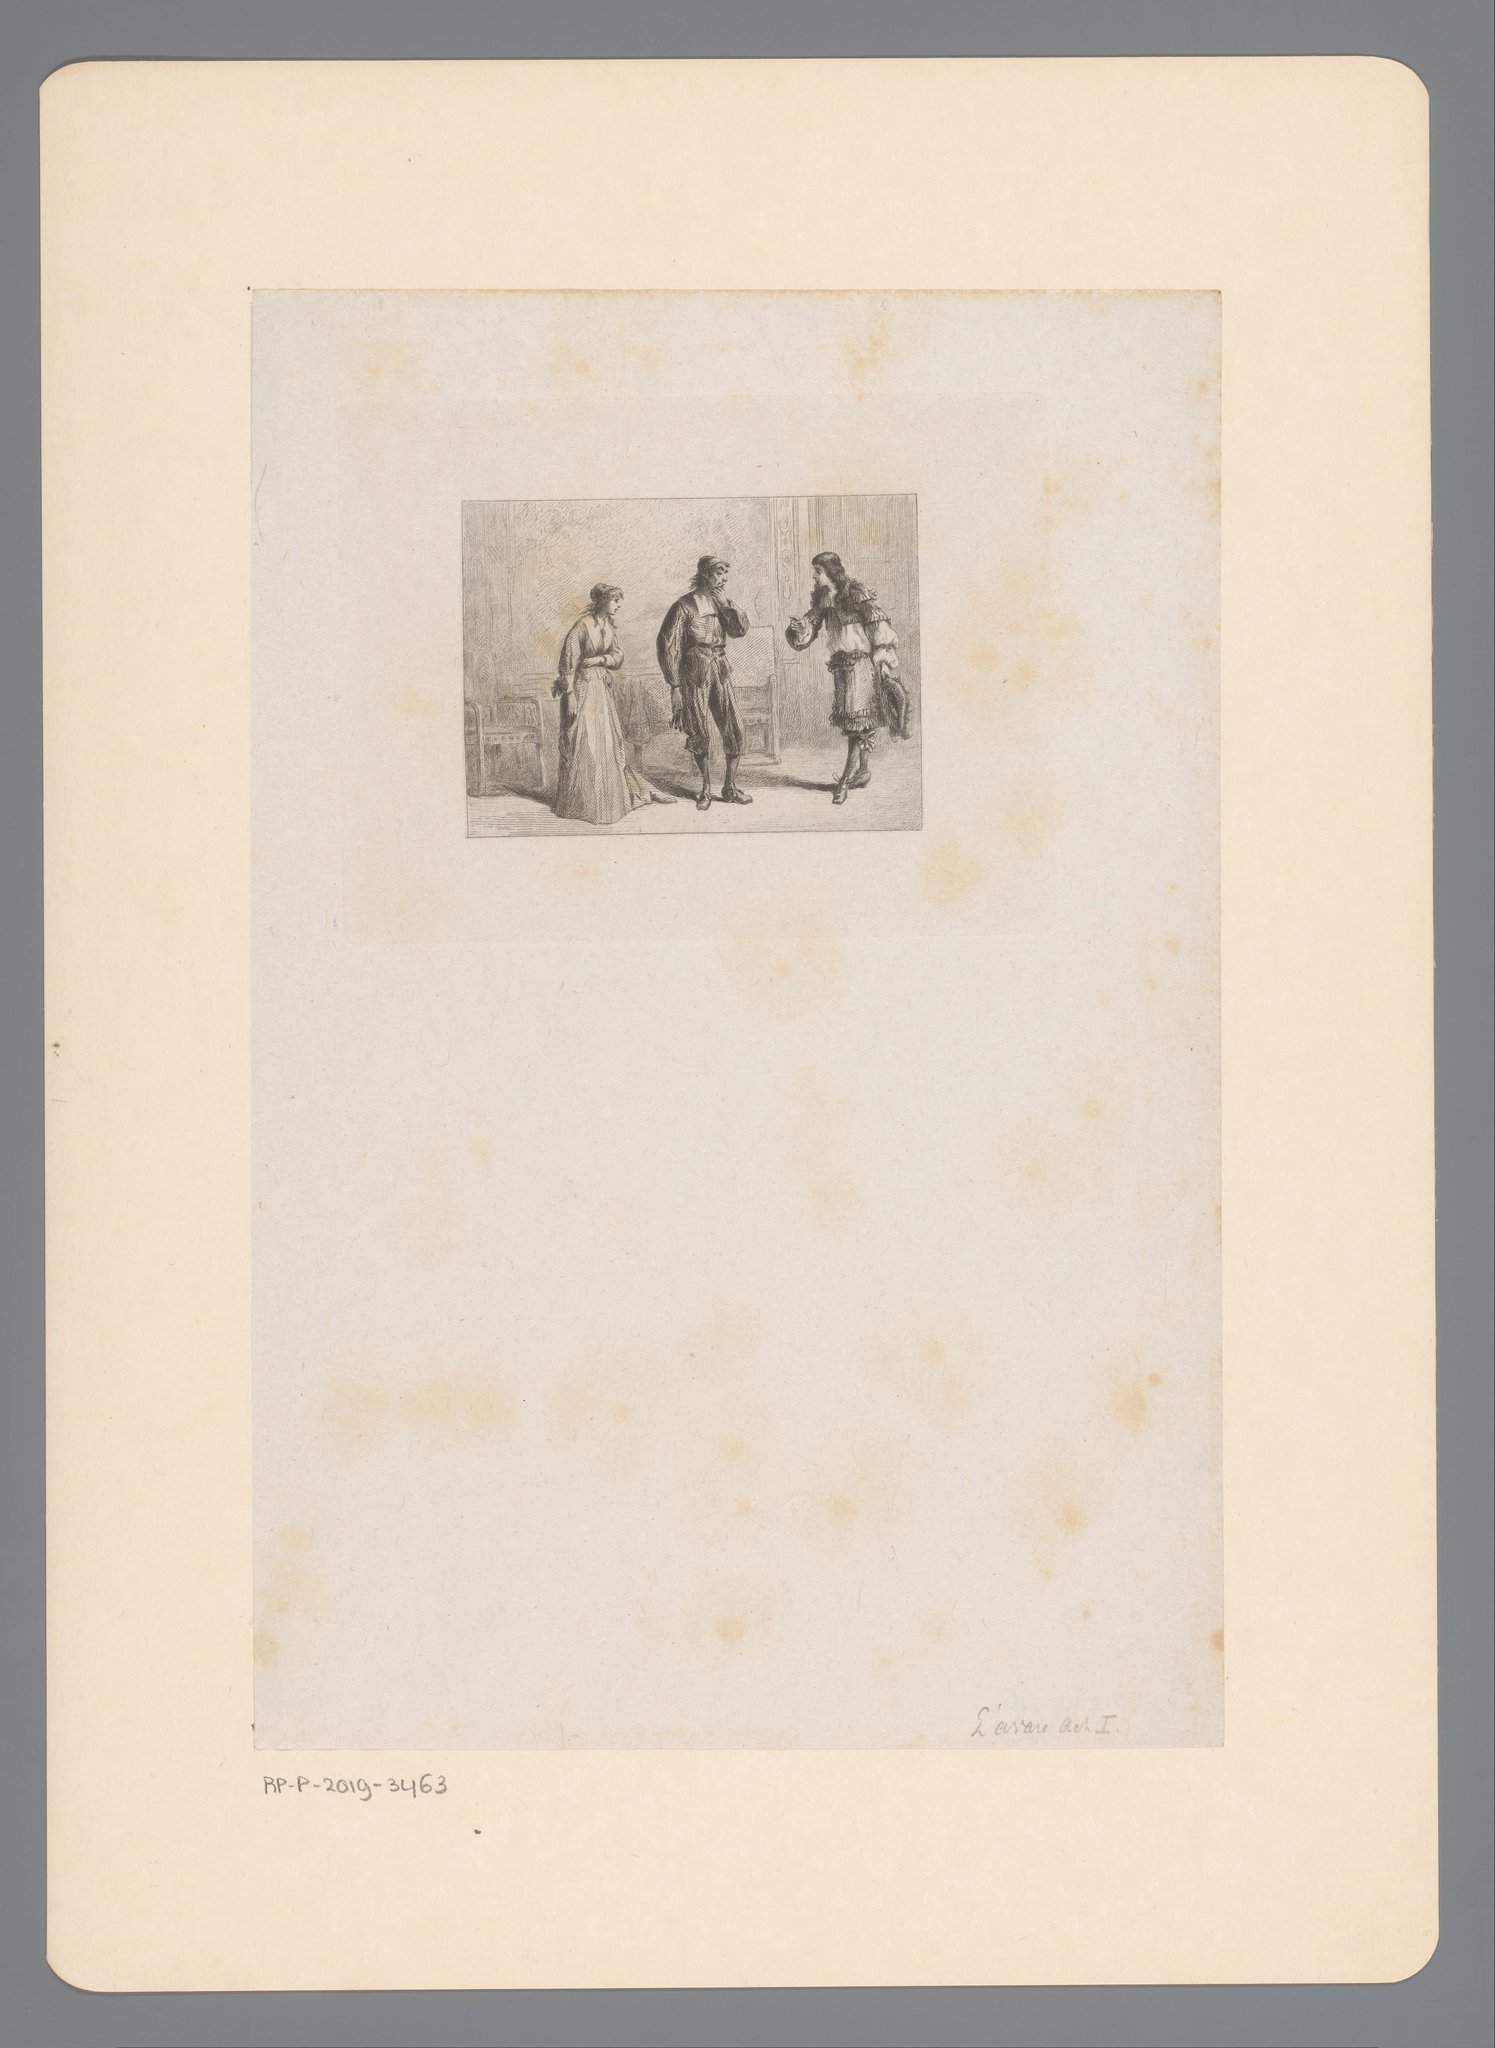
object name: print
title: Molière Théatre Choisi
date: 1878-1879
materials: paper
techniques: drypoint, etching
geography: tours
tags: theatre, theatrical performance, miser, betrothal and marriage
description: Akte I, scène V uit "L'Avare" van Molière. Harpagon bespreekt de huwelijksplannen voor zijn dochter Élise met Valère, haar geheime geliefde.